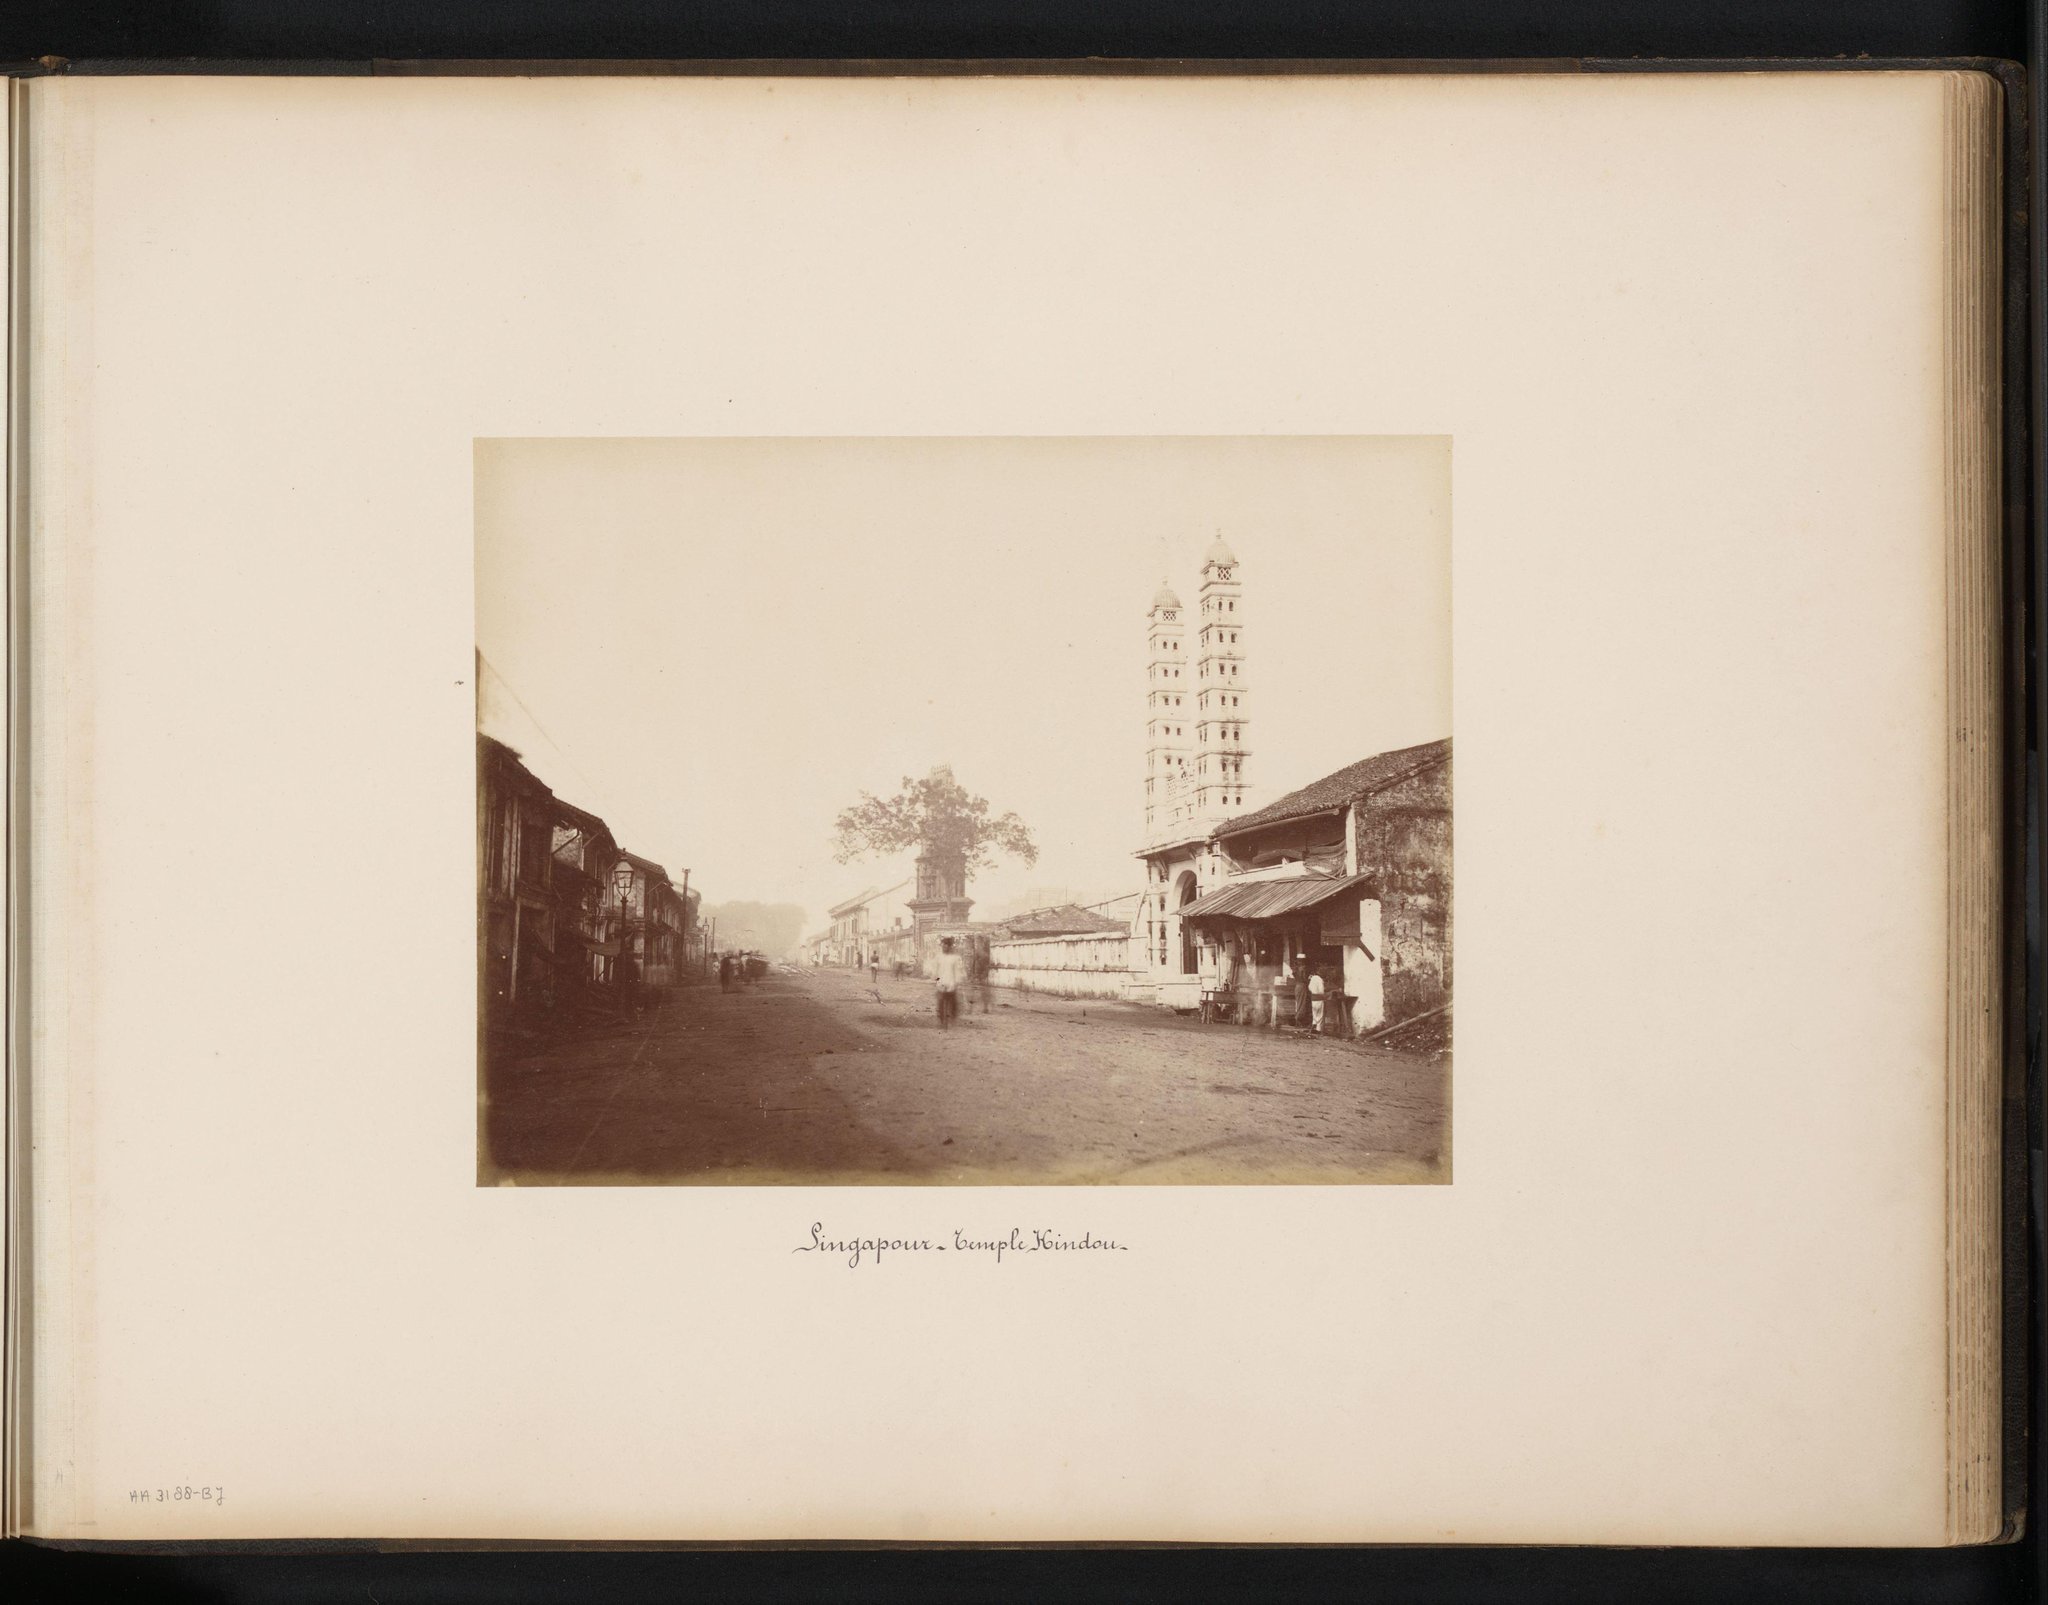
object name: photograph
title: South Bridge Road in Singapore with the Sri Mariamman temple in the middle and a mosque to the right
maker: Anonymous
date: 1880-1883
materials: photographic support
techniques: albumen print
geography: singapore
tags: temple, shrine ~ hinduism, buddhism, jainism, temple, shrine ~ islam, mohammedanism, street (+ city(-scape) with figures, staffage), singapore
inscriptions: title: ‘Singapour _ Temple Hindou _’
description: Onderdeel van Reisalbum met opnames van bezienswaardigheden in Egypte, Nederlands-Indië, Singapore en Ceylon.